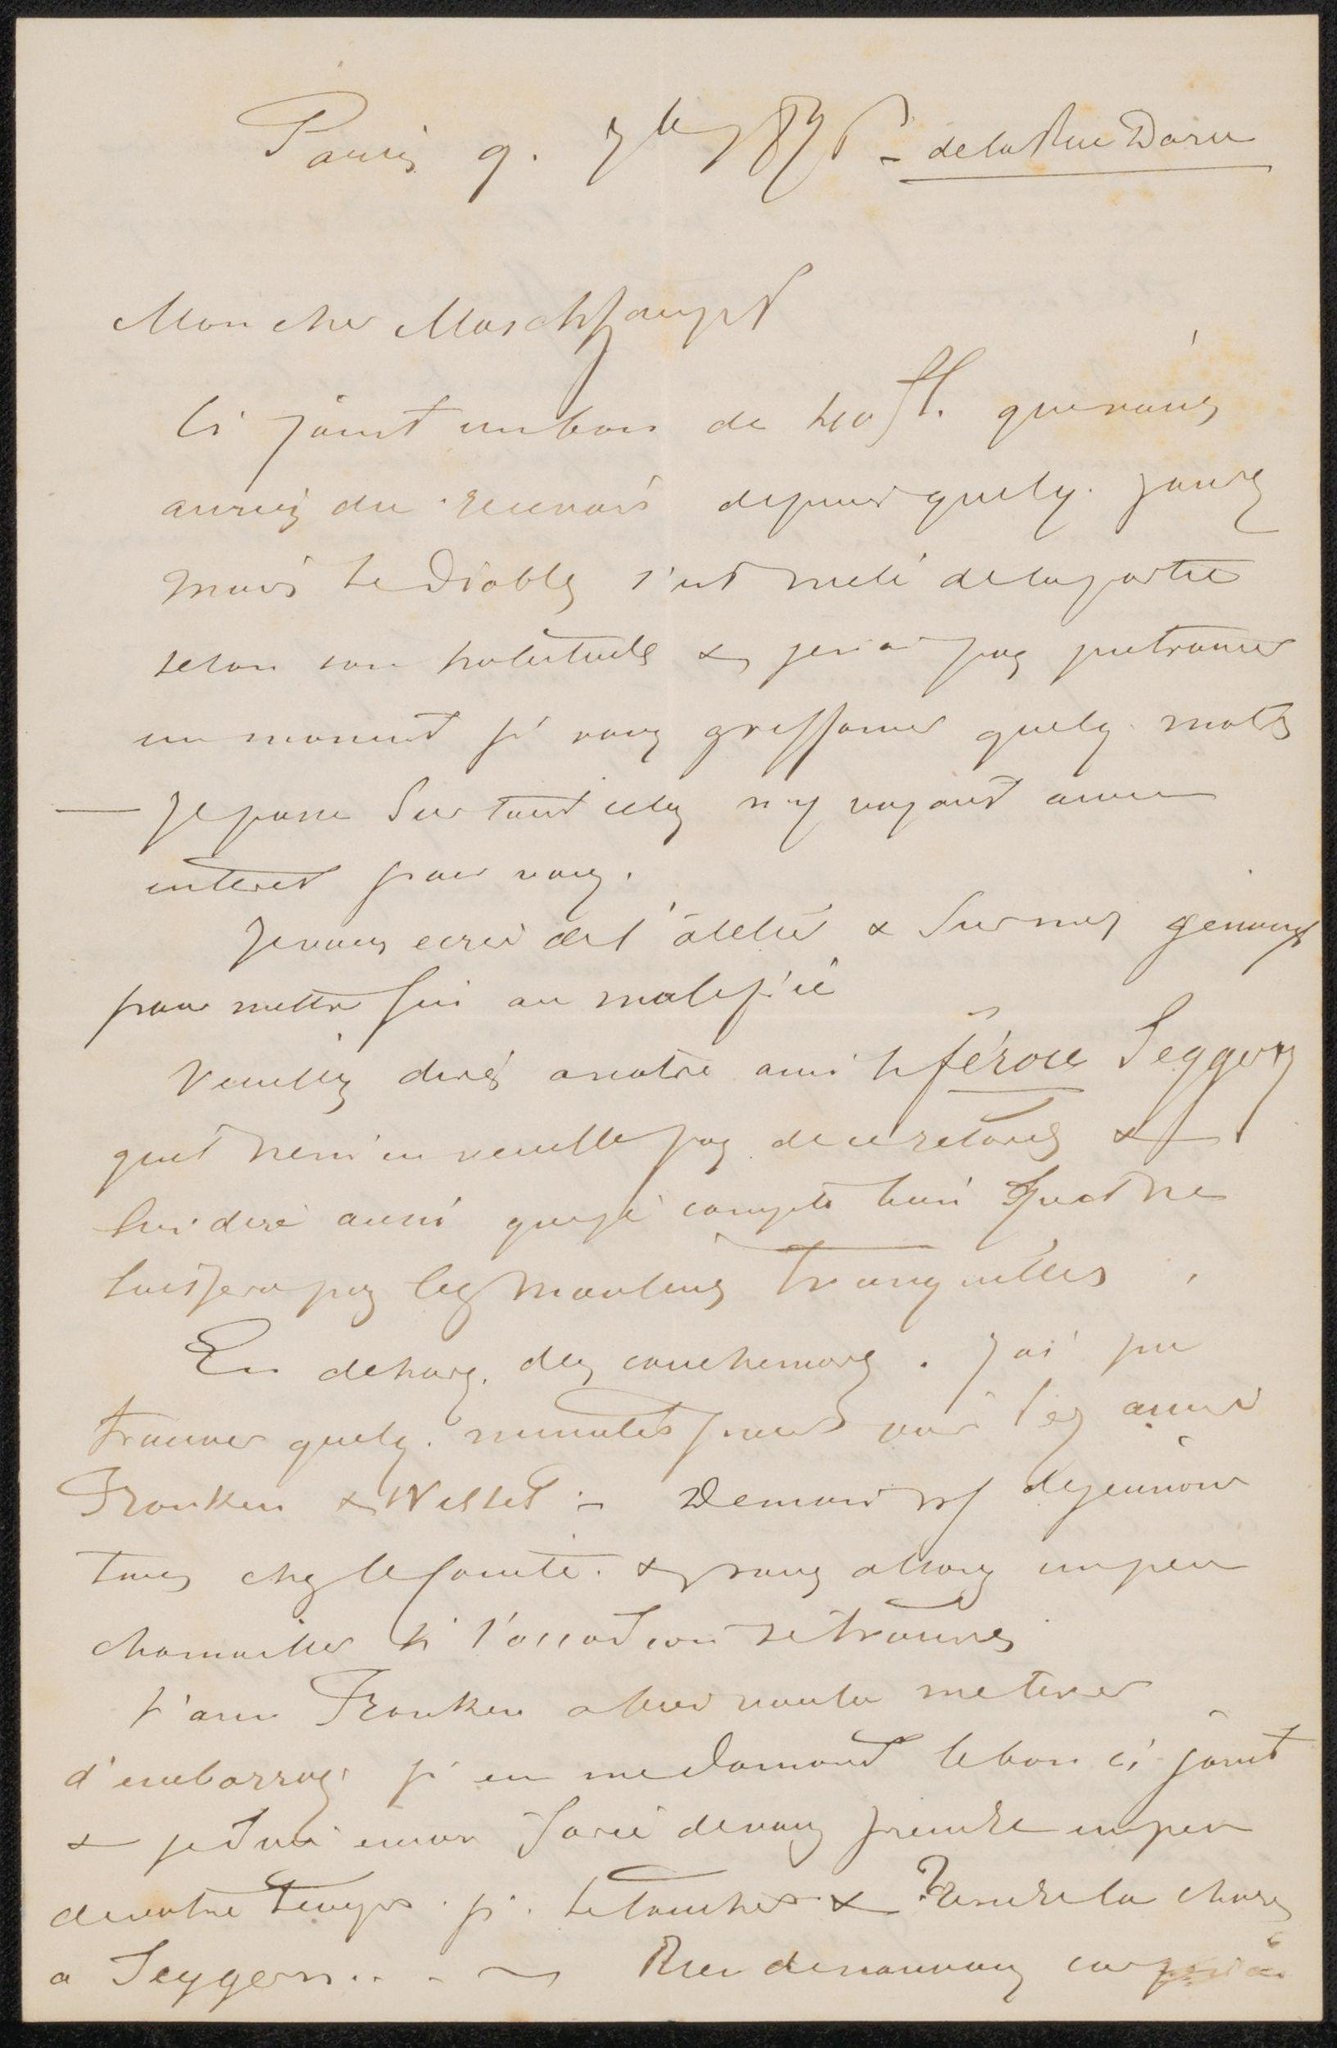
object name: letter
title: Brief aan Jan Hendrik Maschaupt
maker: adolphe mouilleron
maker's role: draughtsman, print maker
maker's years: 1820-1881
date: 1876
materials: ink, paper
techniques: pen, writing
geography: paris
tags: painter, jan hendrik maschaupt, eugène fromentin-dupeux, leiden, rembrandt van rijn, daniël franken dzn., amsterdam, painting (including book-illumination, miniature-painting), money, brussels, paris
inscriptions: collector's mark: ‘RPK’